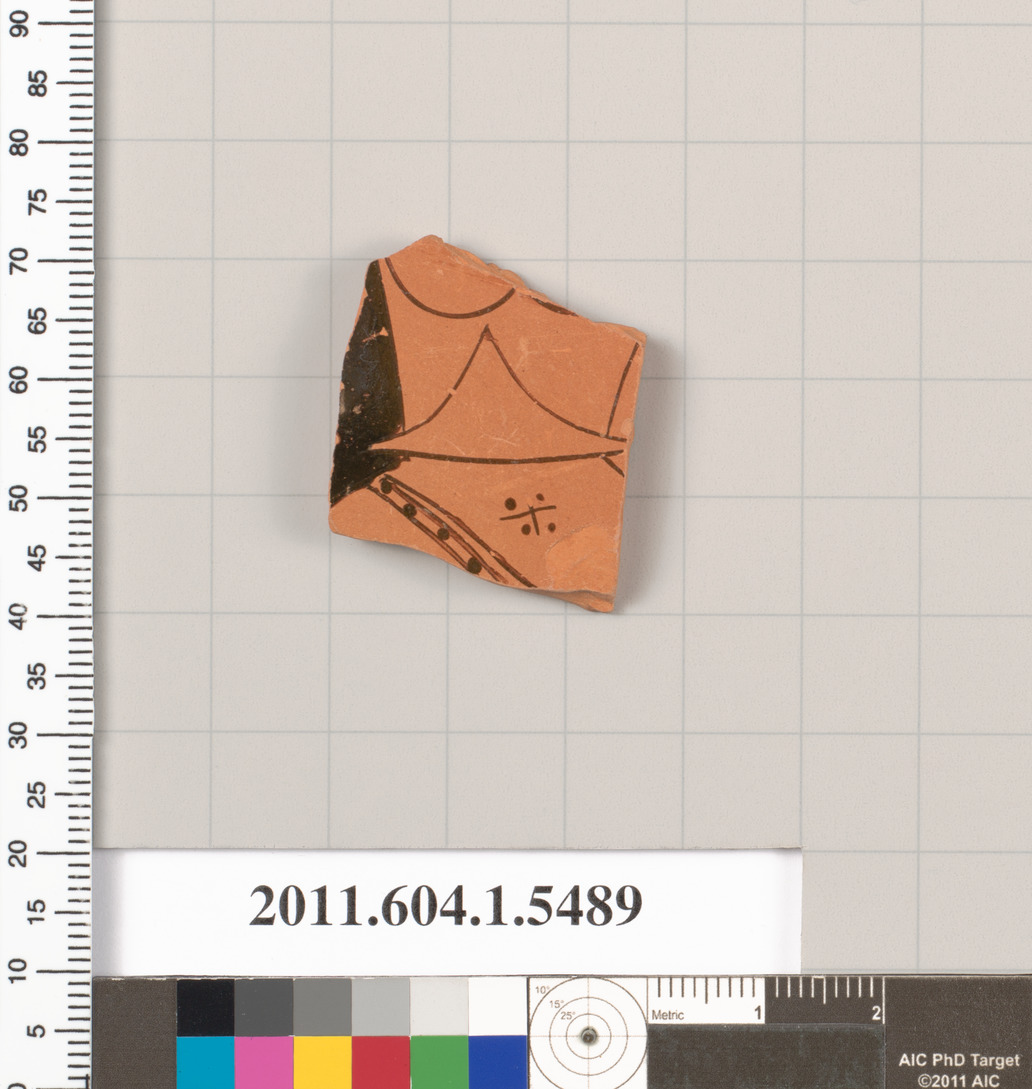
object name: kylix fragment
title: Terracotta fragment of a kylix (drinking cup)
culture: greek, attic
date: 510-500 BCE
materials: terracotta